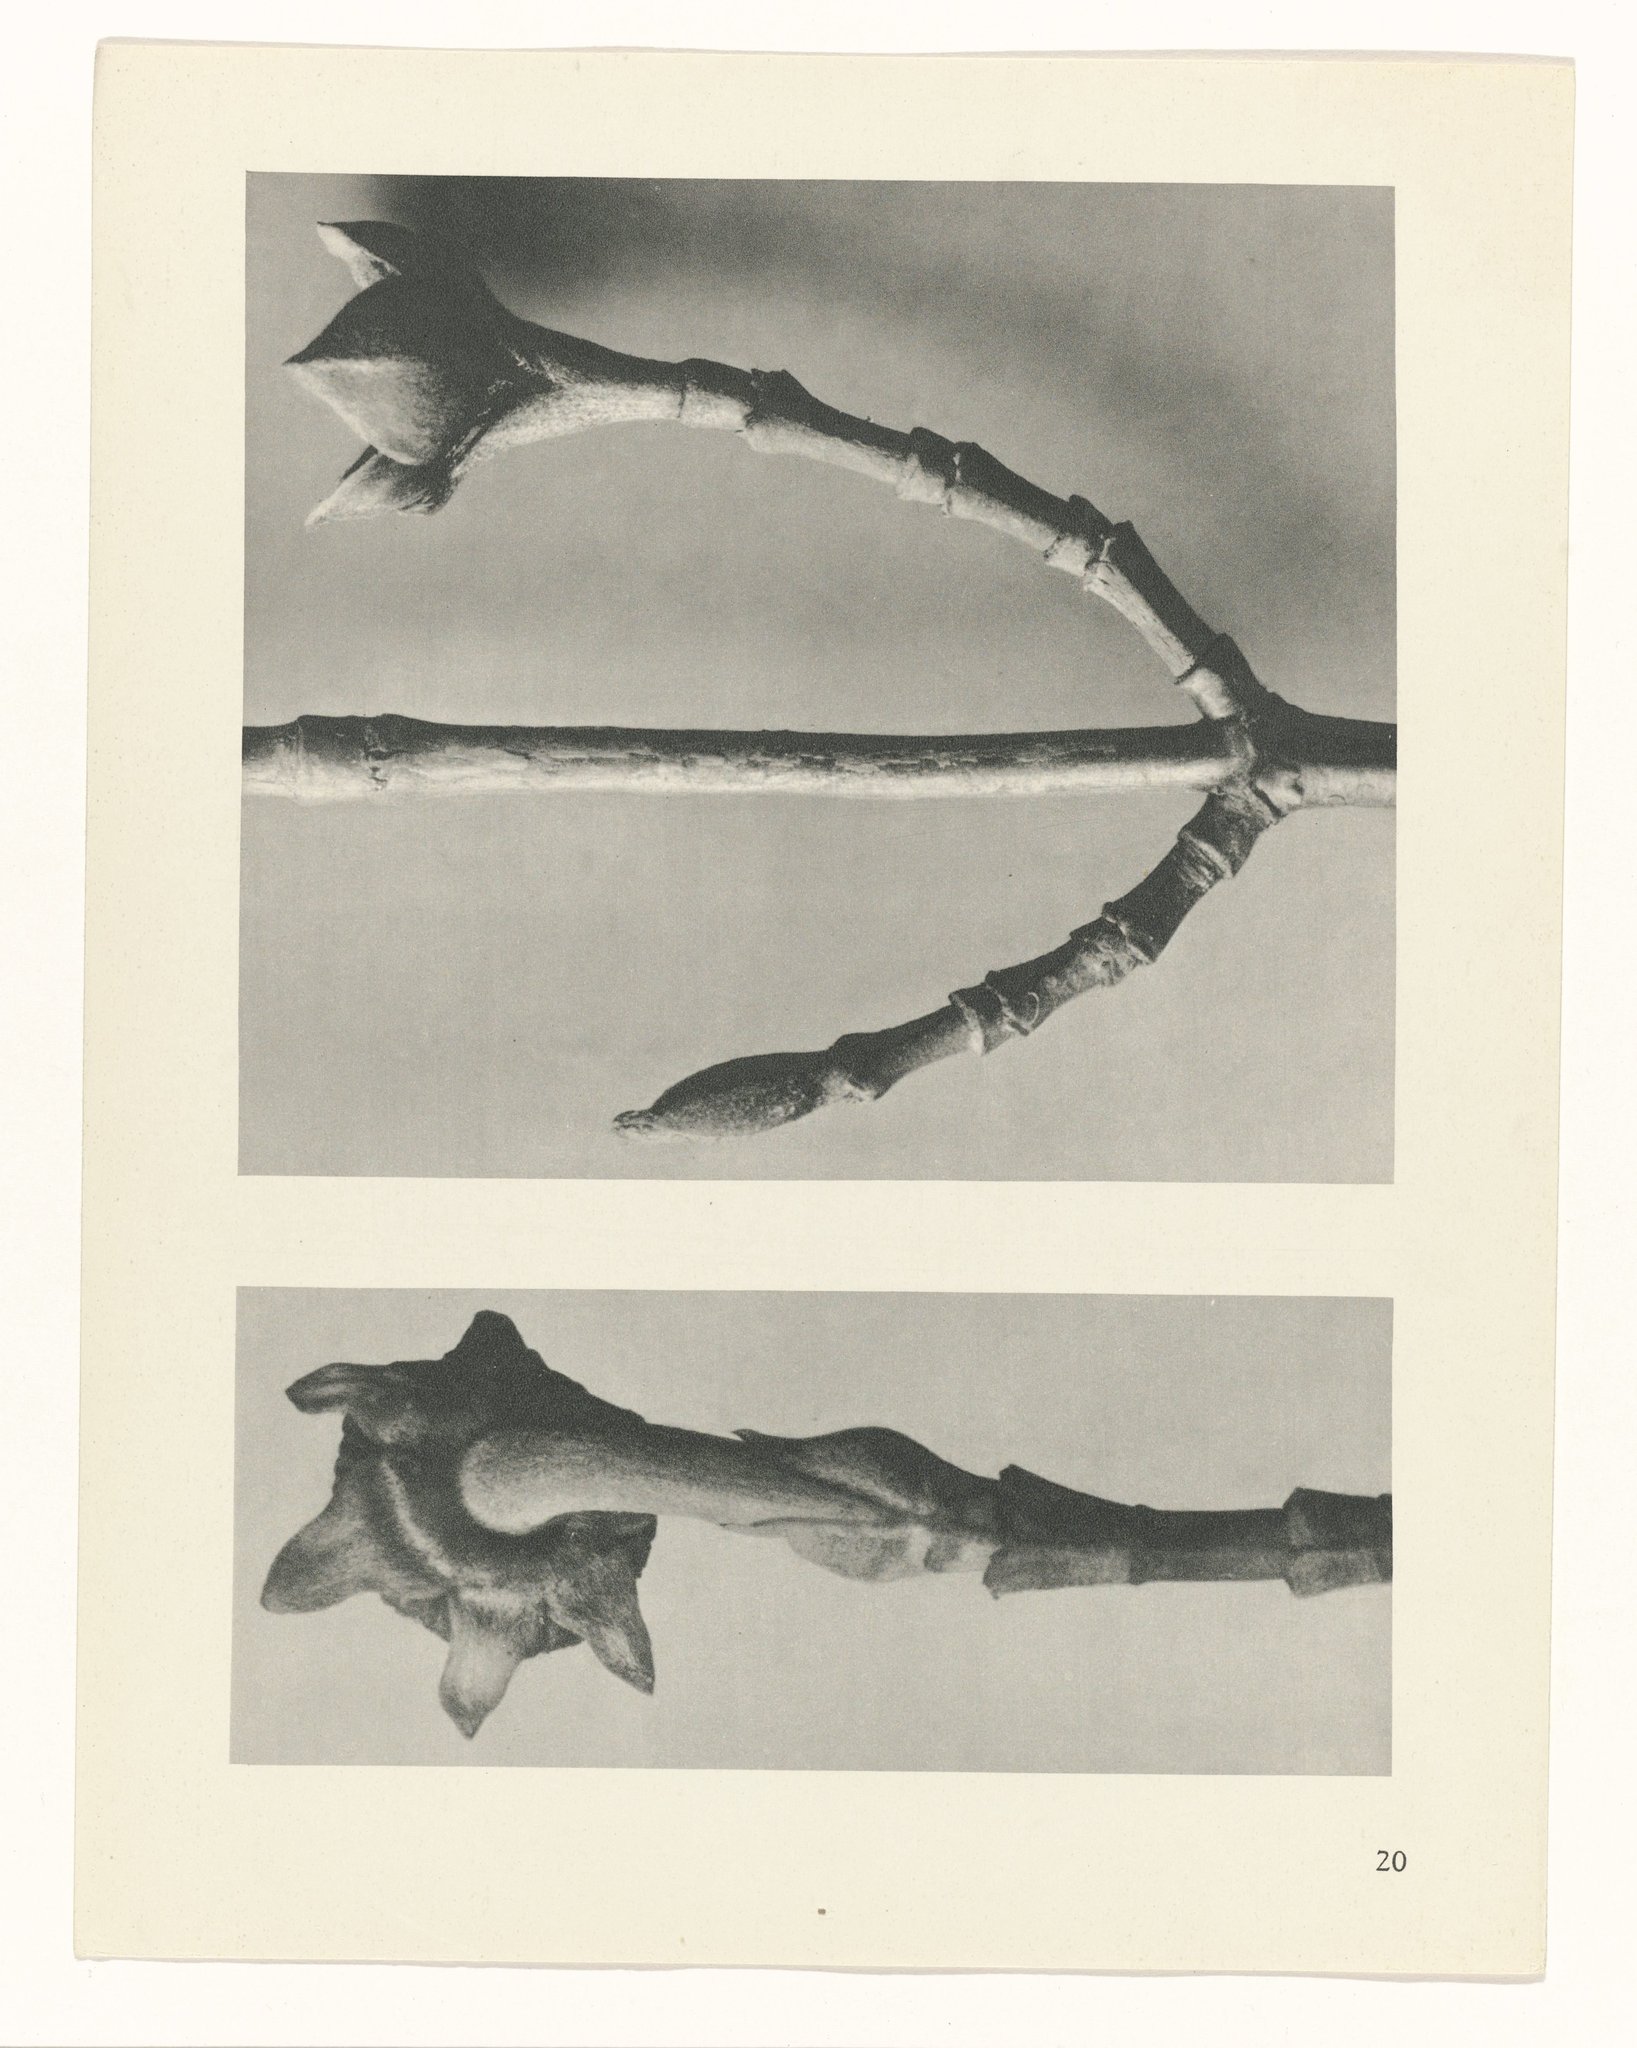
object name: photograph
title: Plantstudie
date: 1928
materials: ink, paper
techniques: rotogravure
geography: berlin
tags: plants (in general)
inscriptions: number: ‘20’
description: facher Vergrößerung. Afkomstig uit losbladige uitgave.